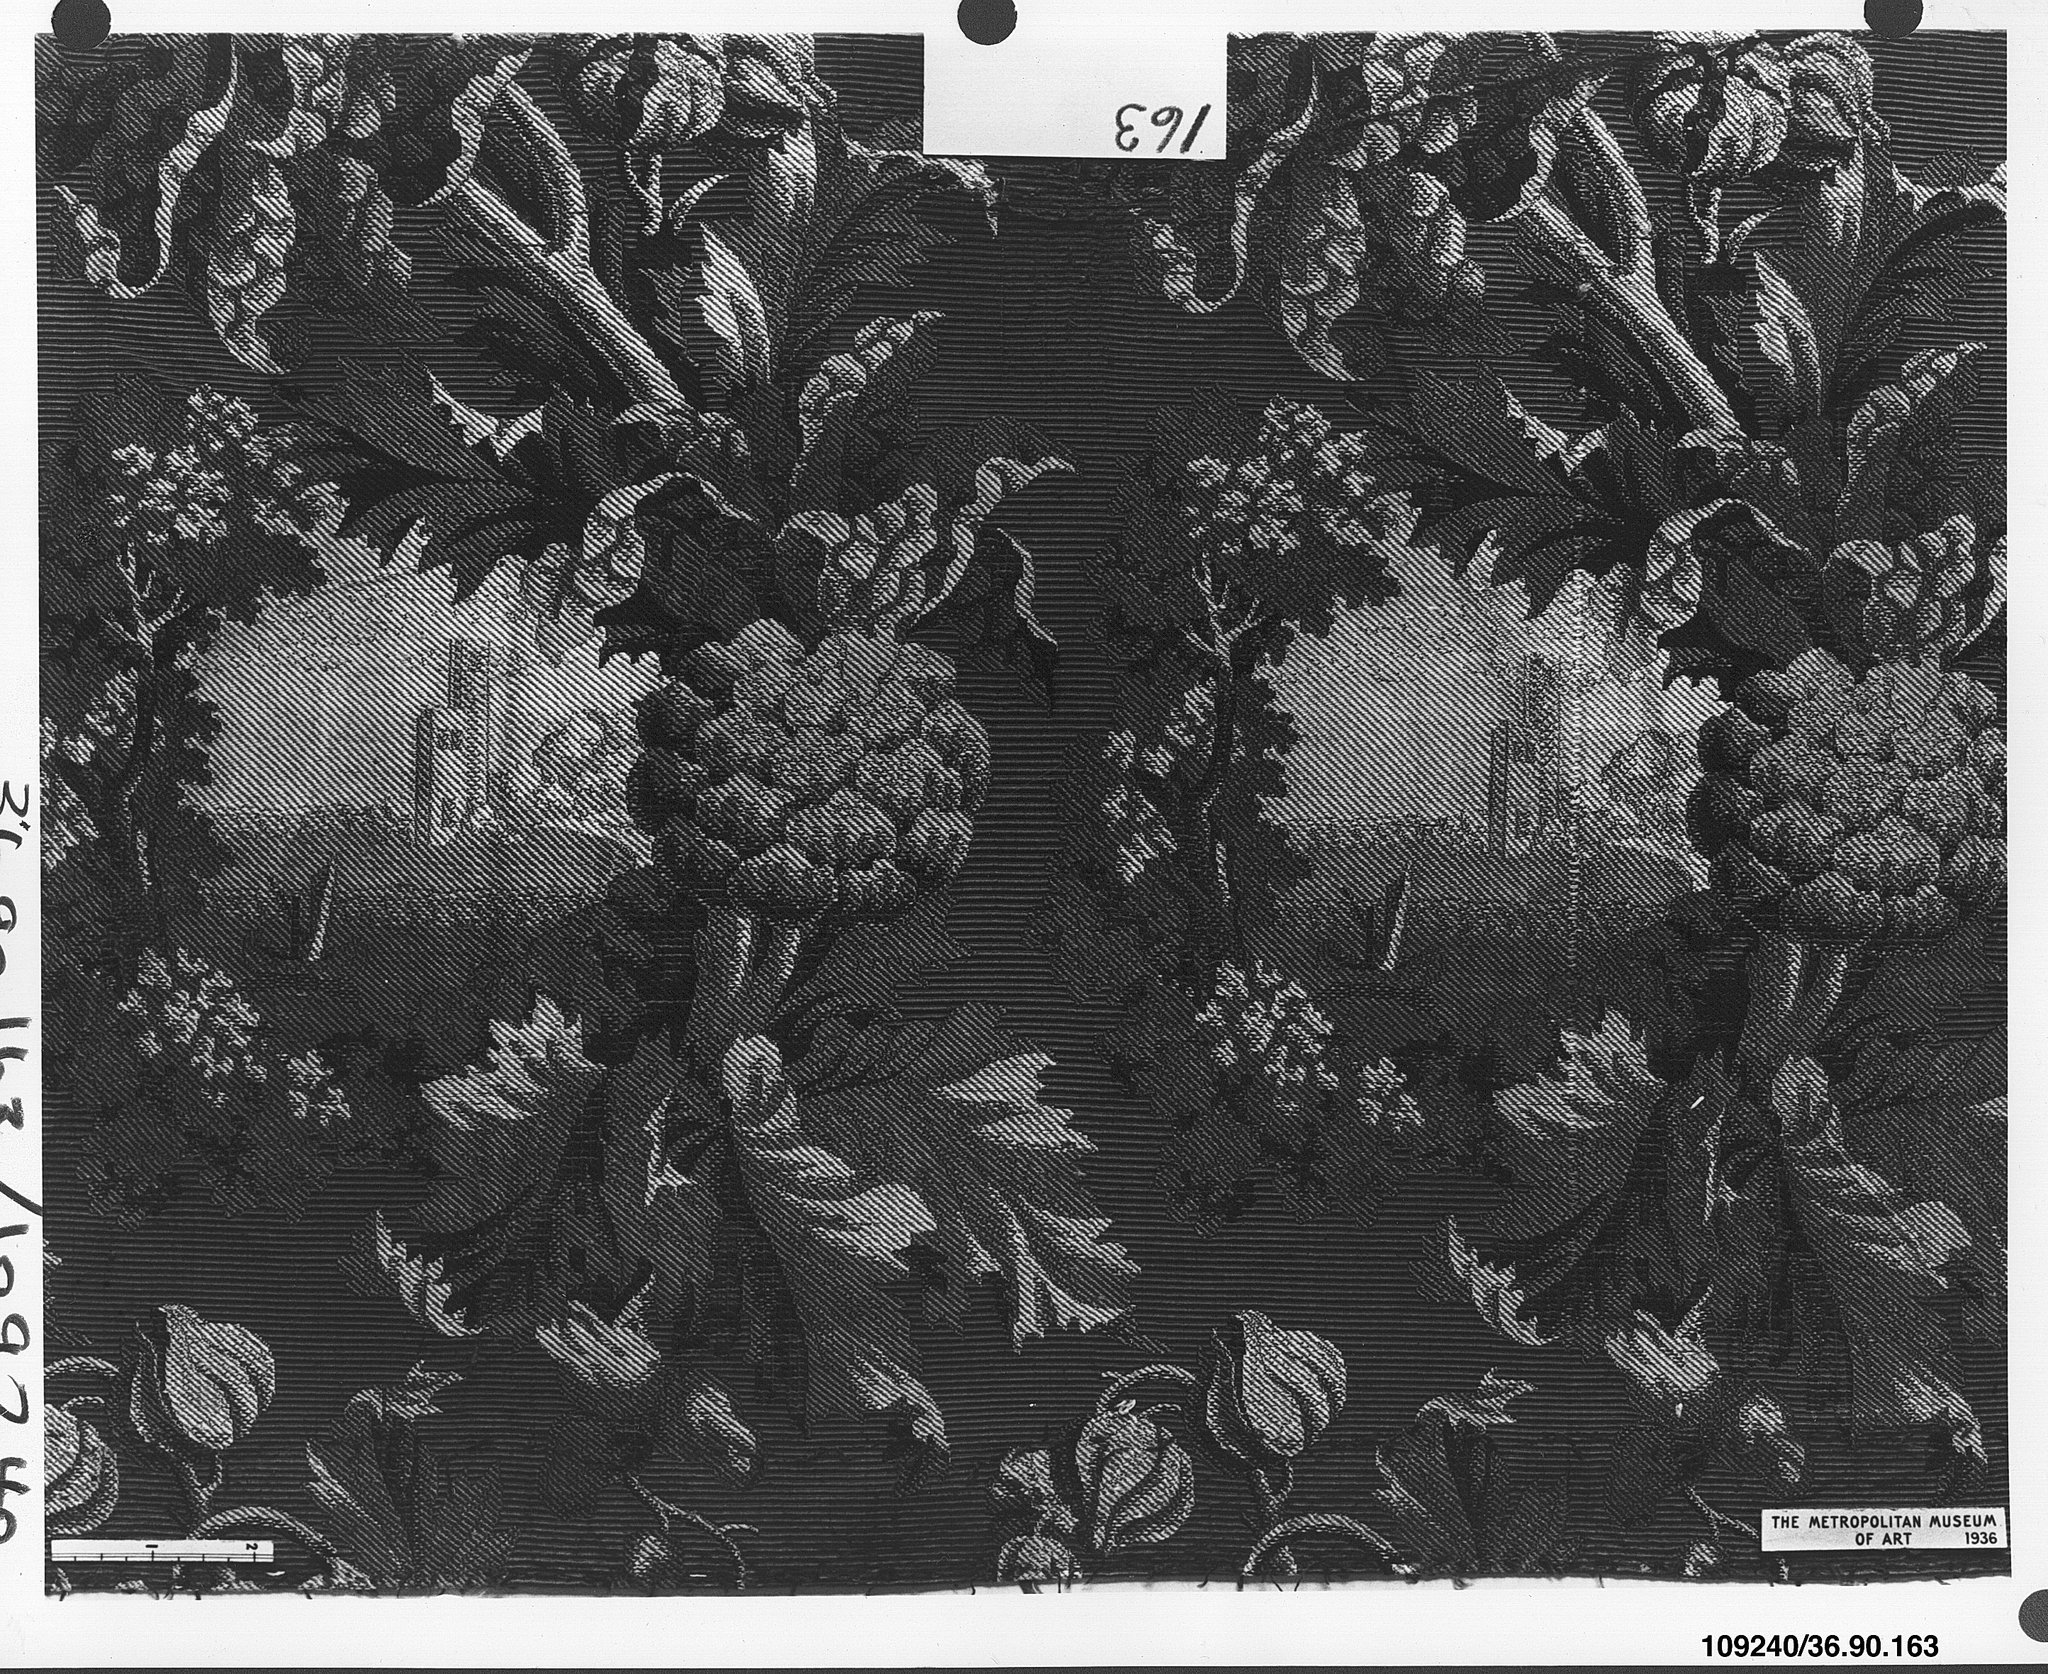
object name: piece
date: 1735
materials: silk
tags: buildings,flowers,leaves